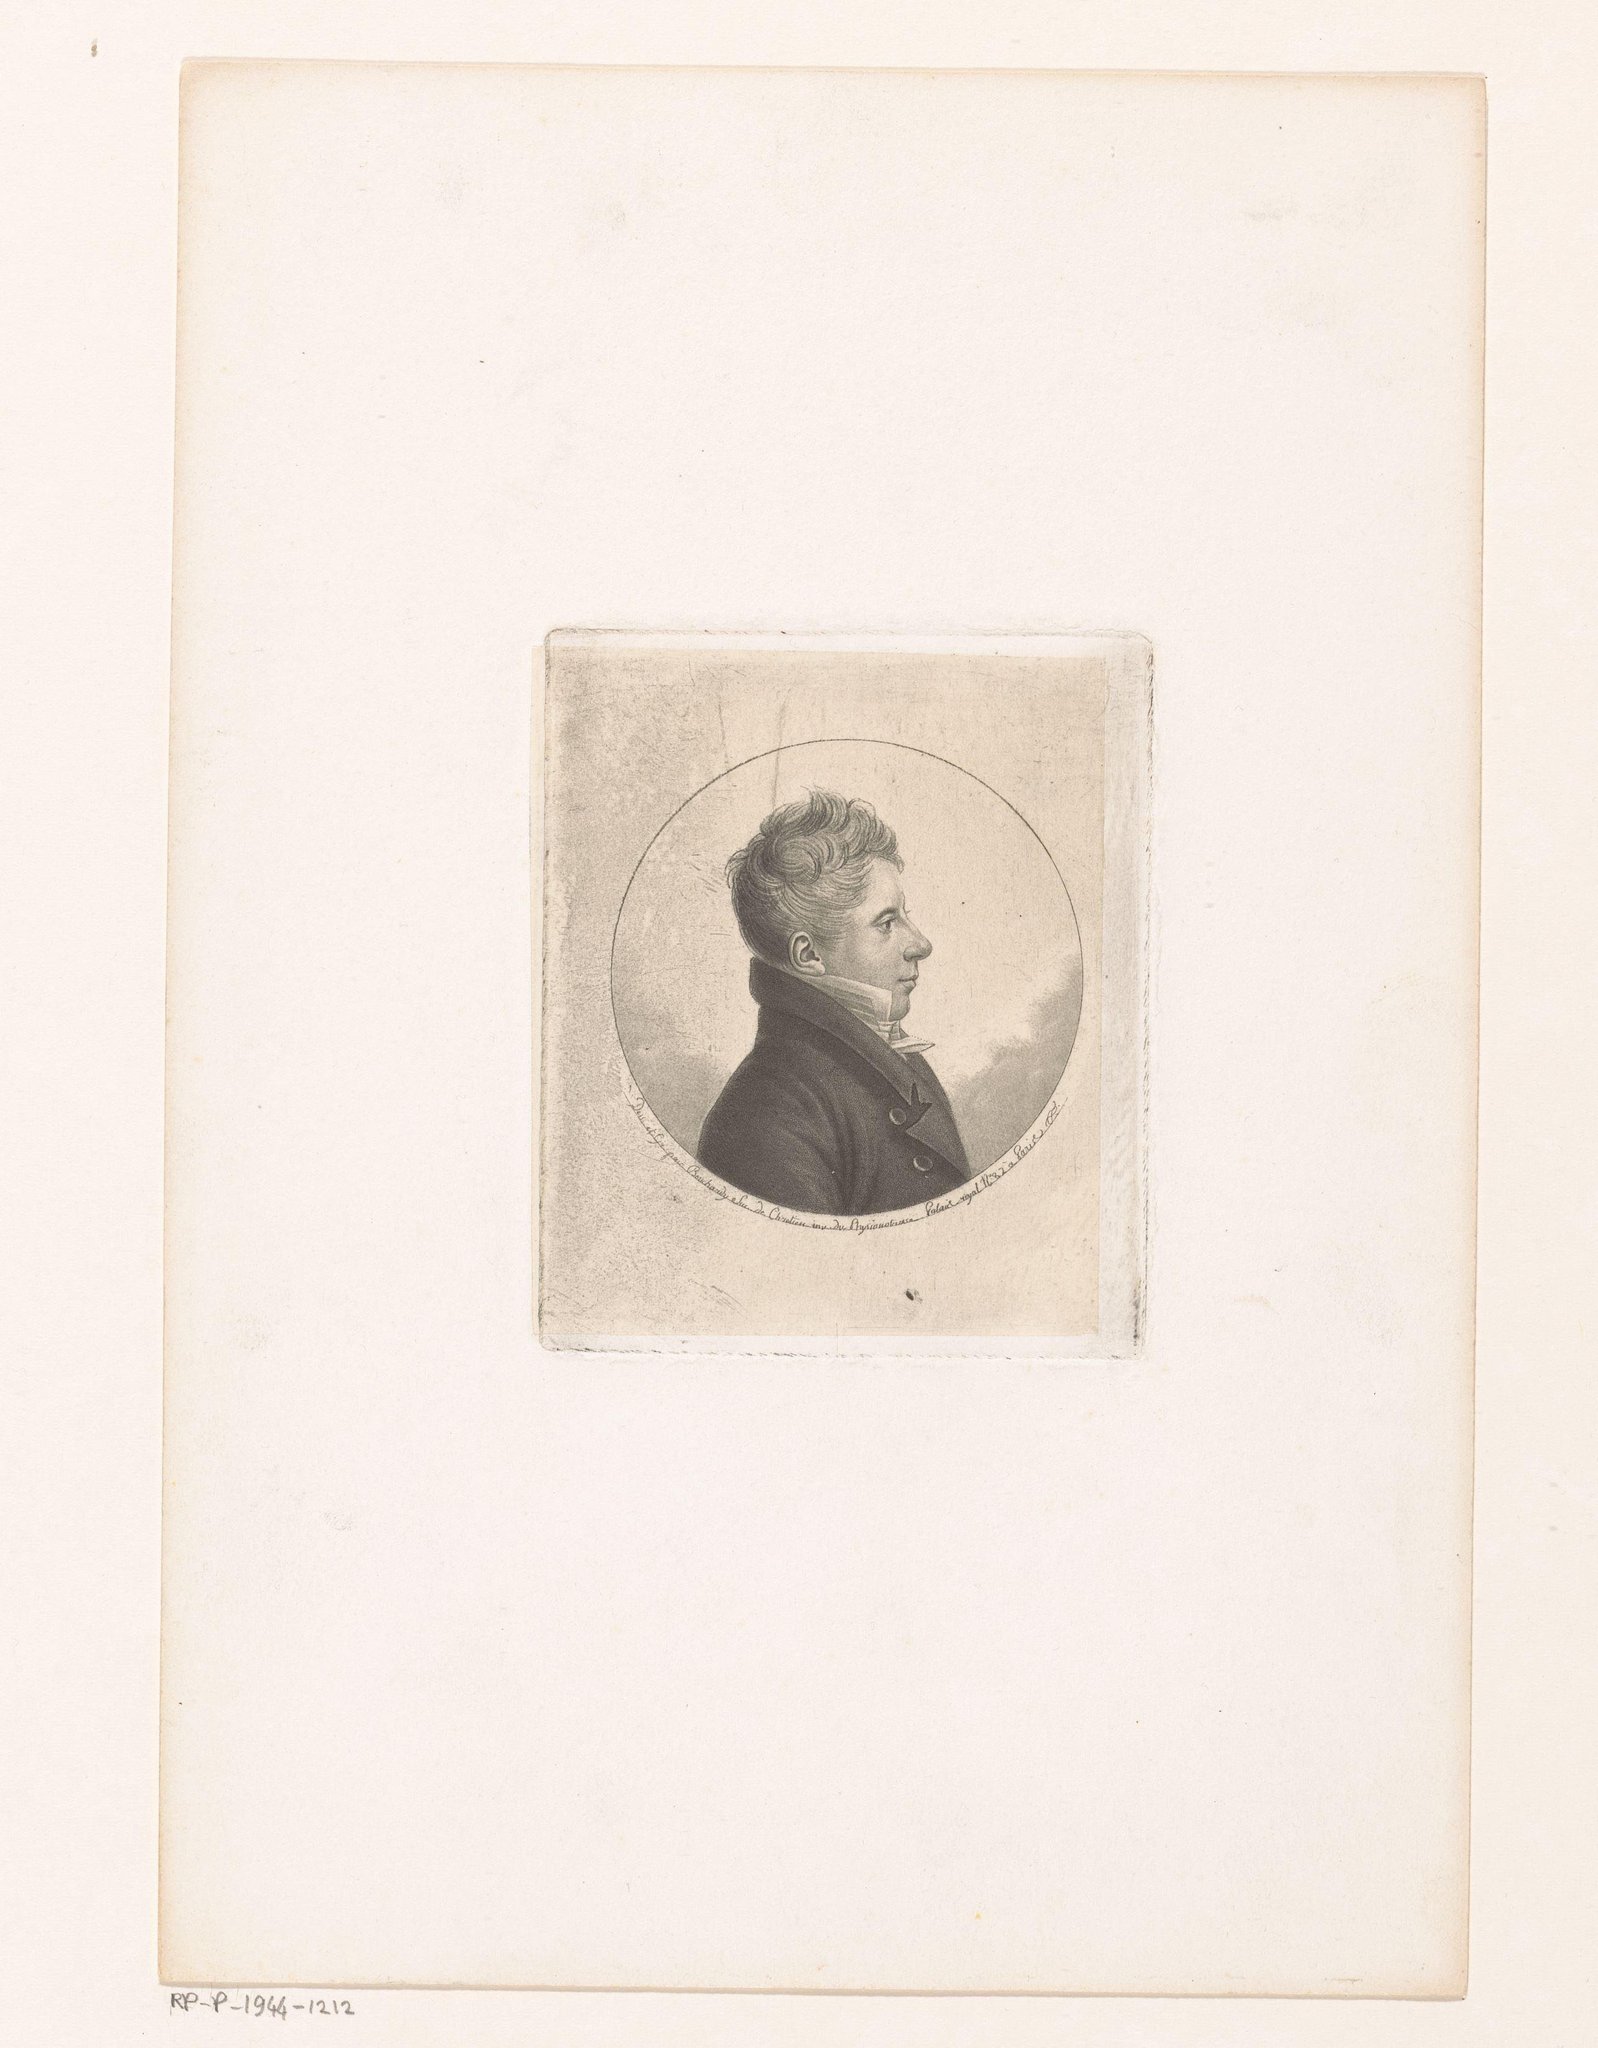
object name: print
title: Portret van een onbekende man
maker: etienne bouchardy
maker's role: print maker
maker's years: 1797-1849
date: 1807-1849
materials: paper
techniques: aquatint, etching, intaglio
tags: historical persons (portraits and scenes from the life)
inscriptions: collector's mark: Lugt 2228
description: Dit portret werd volgens het opschrift vervaardigd met behulp van een physionotrace, waarmee de contouren van een gezicht op een stuk papier konden worden overgebracht.